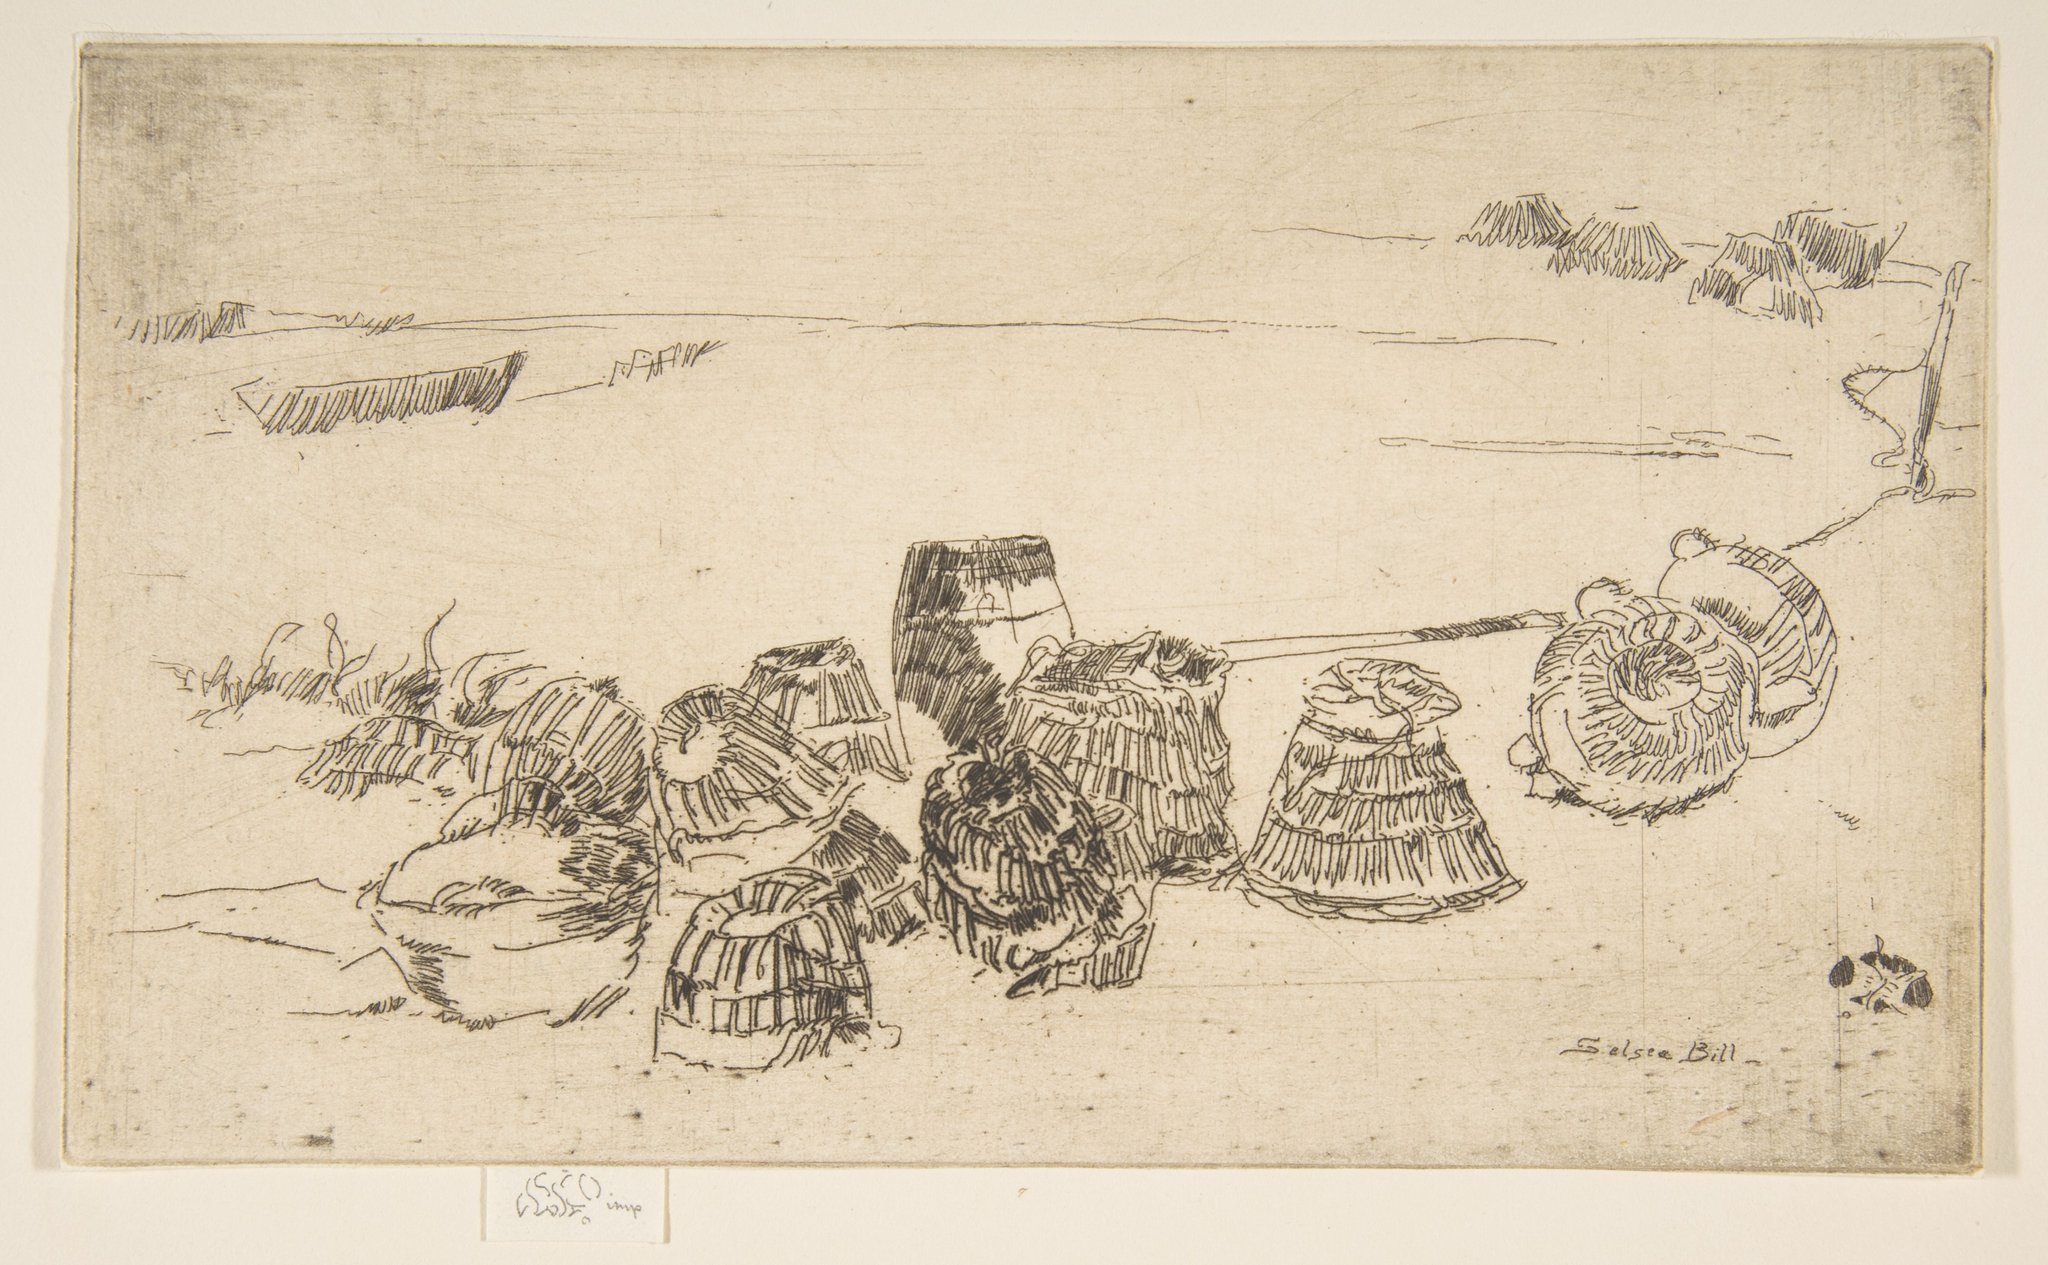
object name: print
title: Lobster Pots (Lobster Pots – Selsea Bill)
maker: james mcneill whistler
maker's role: artist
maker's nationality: american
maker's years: 1834-1903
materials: ink, paper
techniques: etching, printing